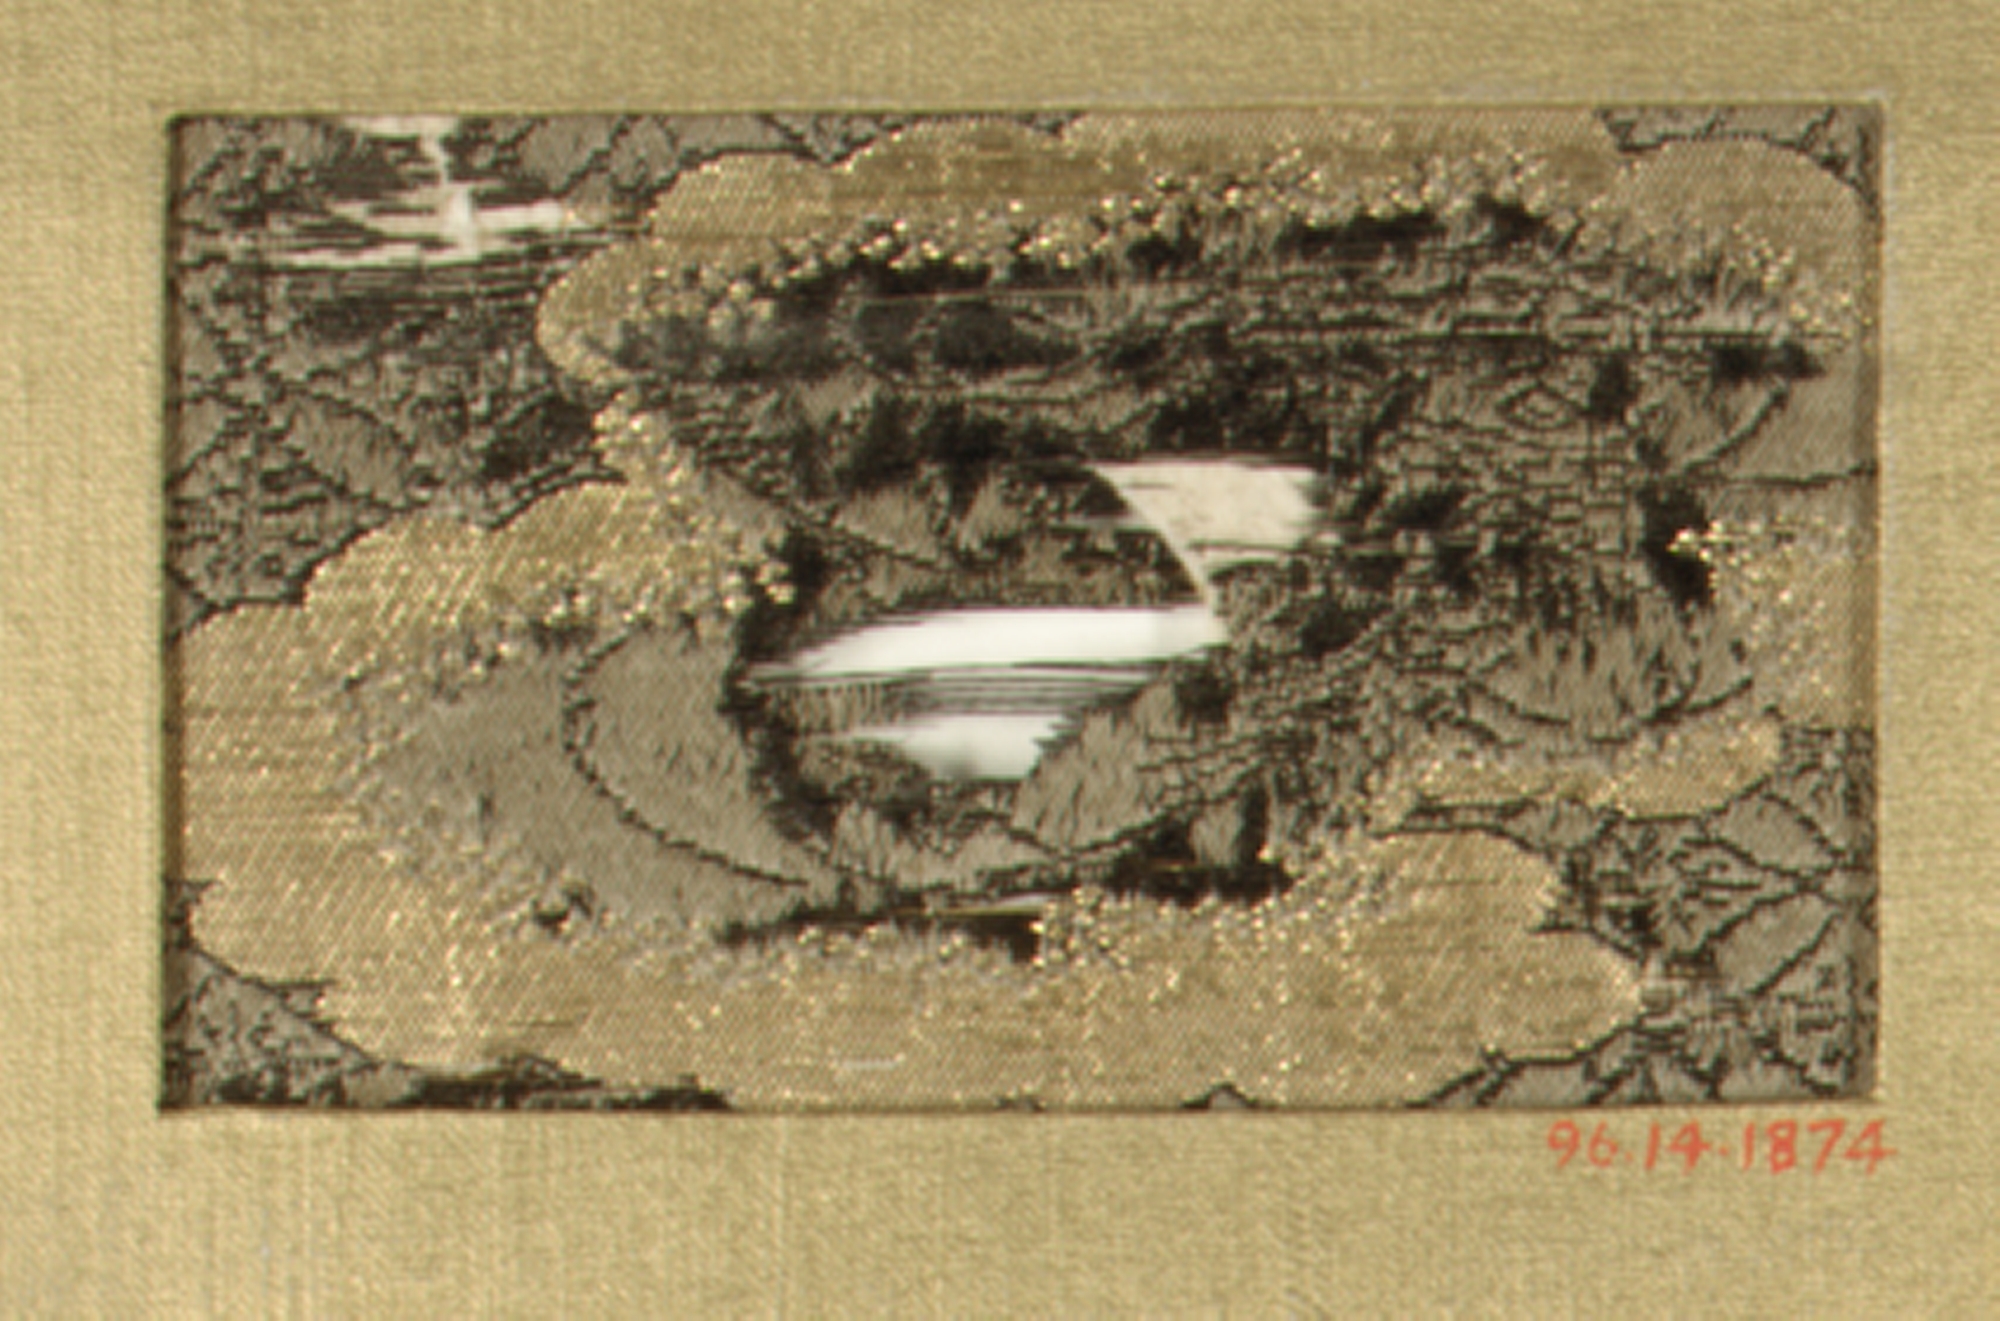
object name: piece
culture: japanese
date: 1701-1900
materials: silk